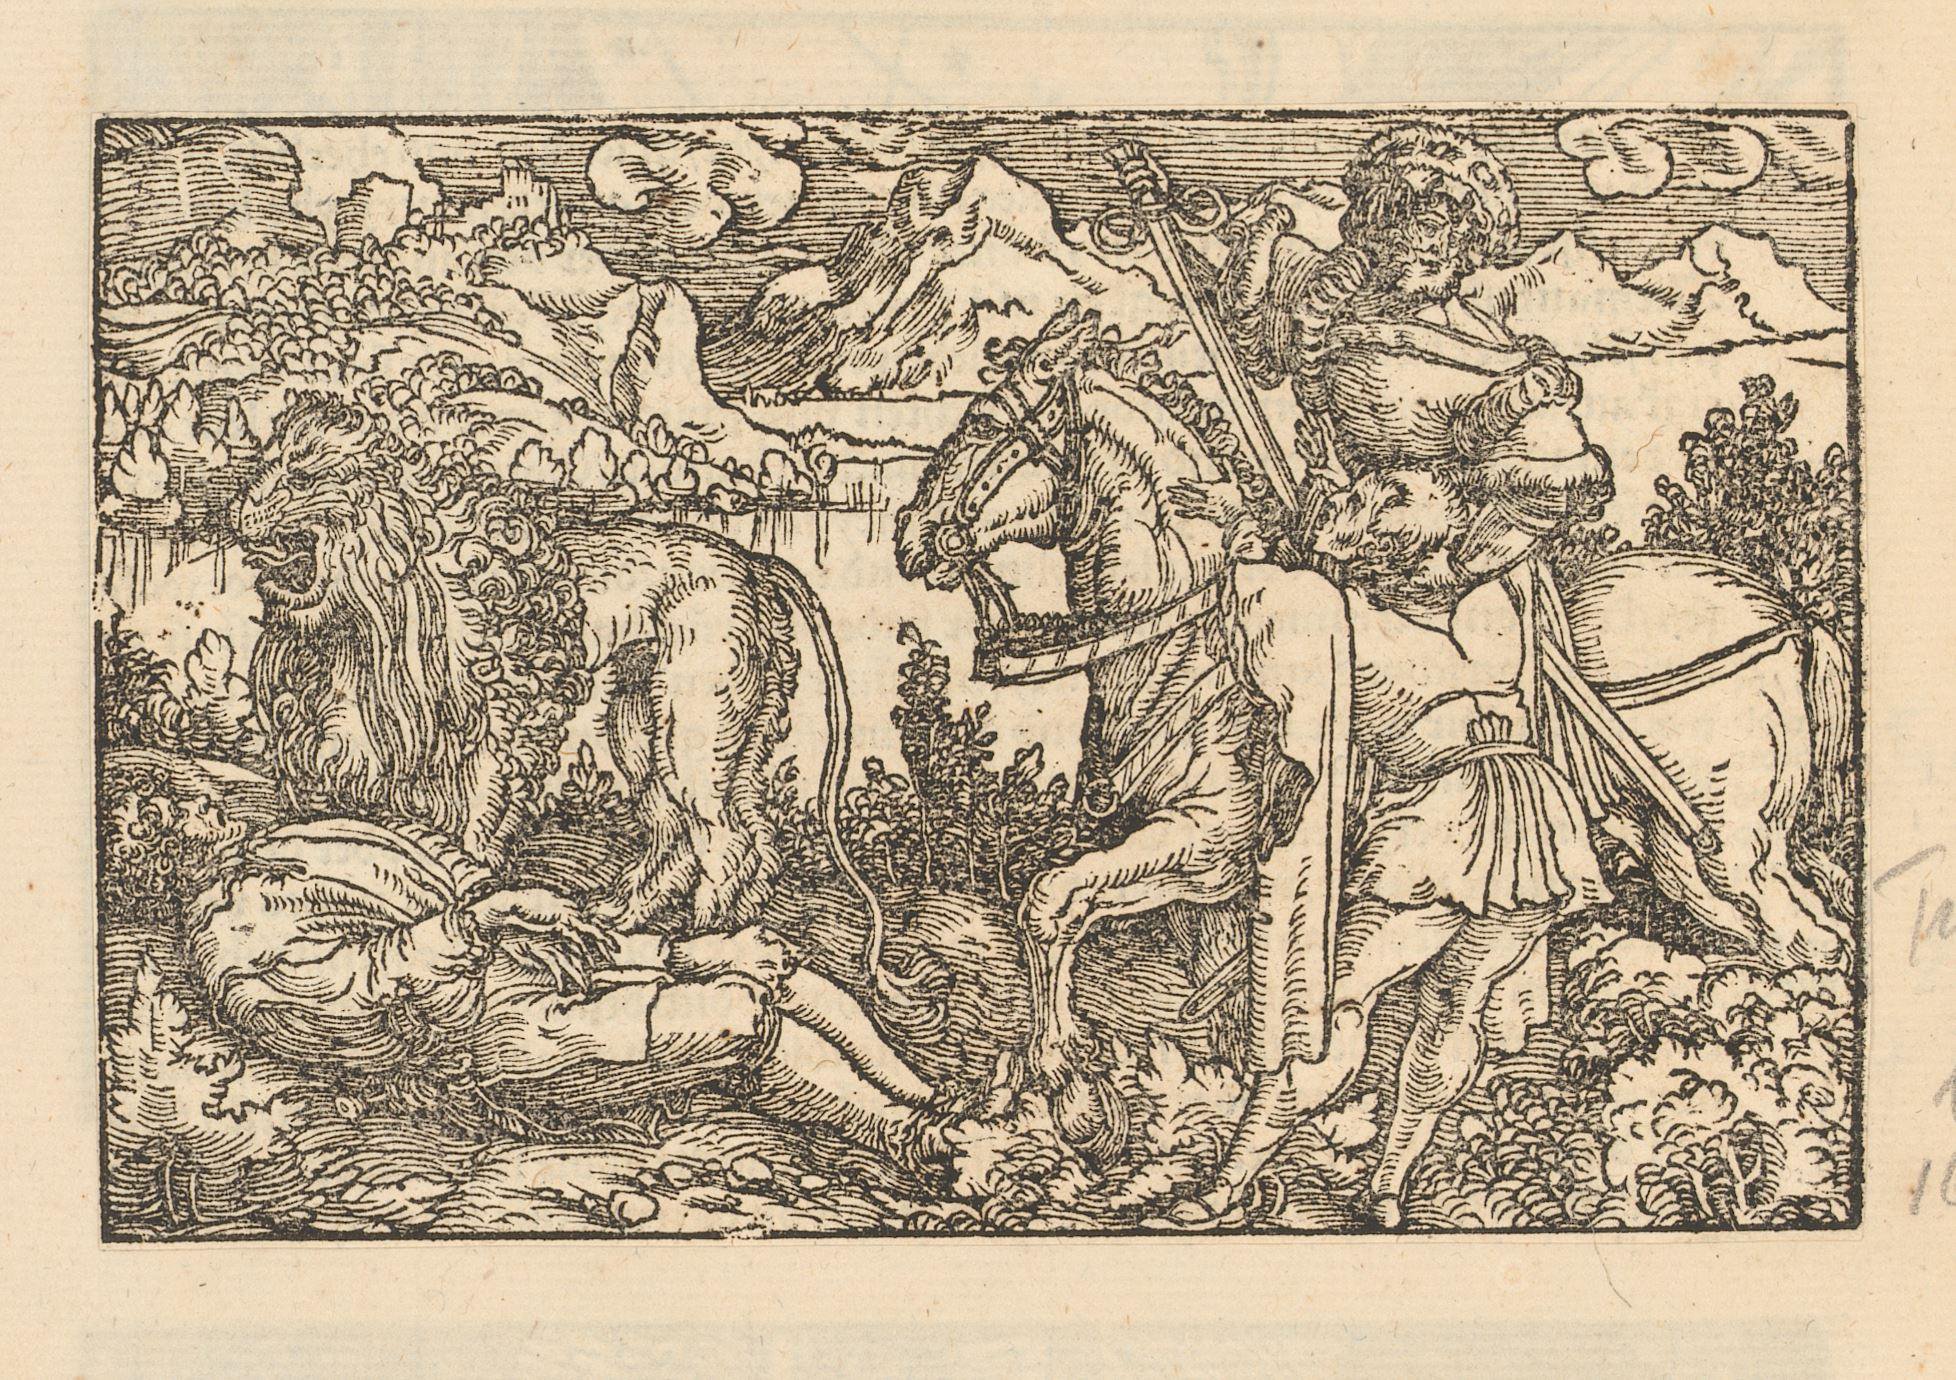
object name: album leaf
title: Ruiter steekt iemand neer, een leeuw en een vastgebonden man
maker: Anonymous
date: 1514-1532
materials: paper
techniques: letterpress printing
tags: prisoner with hands bound, beasts of prey, predatory animals: lion (+ heraldic animals), blood-revenge, vendetta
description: Deze prent is gebruikt in: Petrarca, Francesco. Von der Artzney bayder Glück, des guten und widerwertigen: unnd weß sich ain yeder inn Gelück und Unglück halten sol (...). Augsburg: Heinrich Steiner, 1532. Deze uitgave is ook bekend onder de titel 'Trostspiegel in Glück und Unglück'.